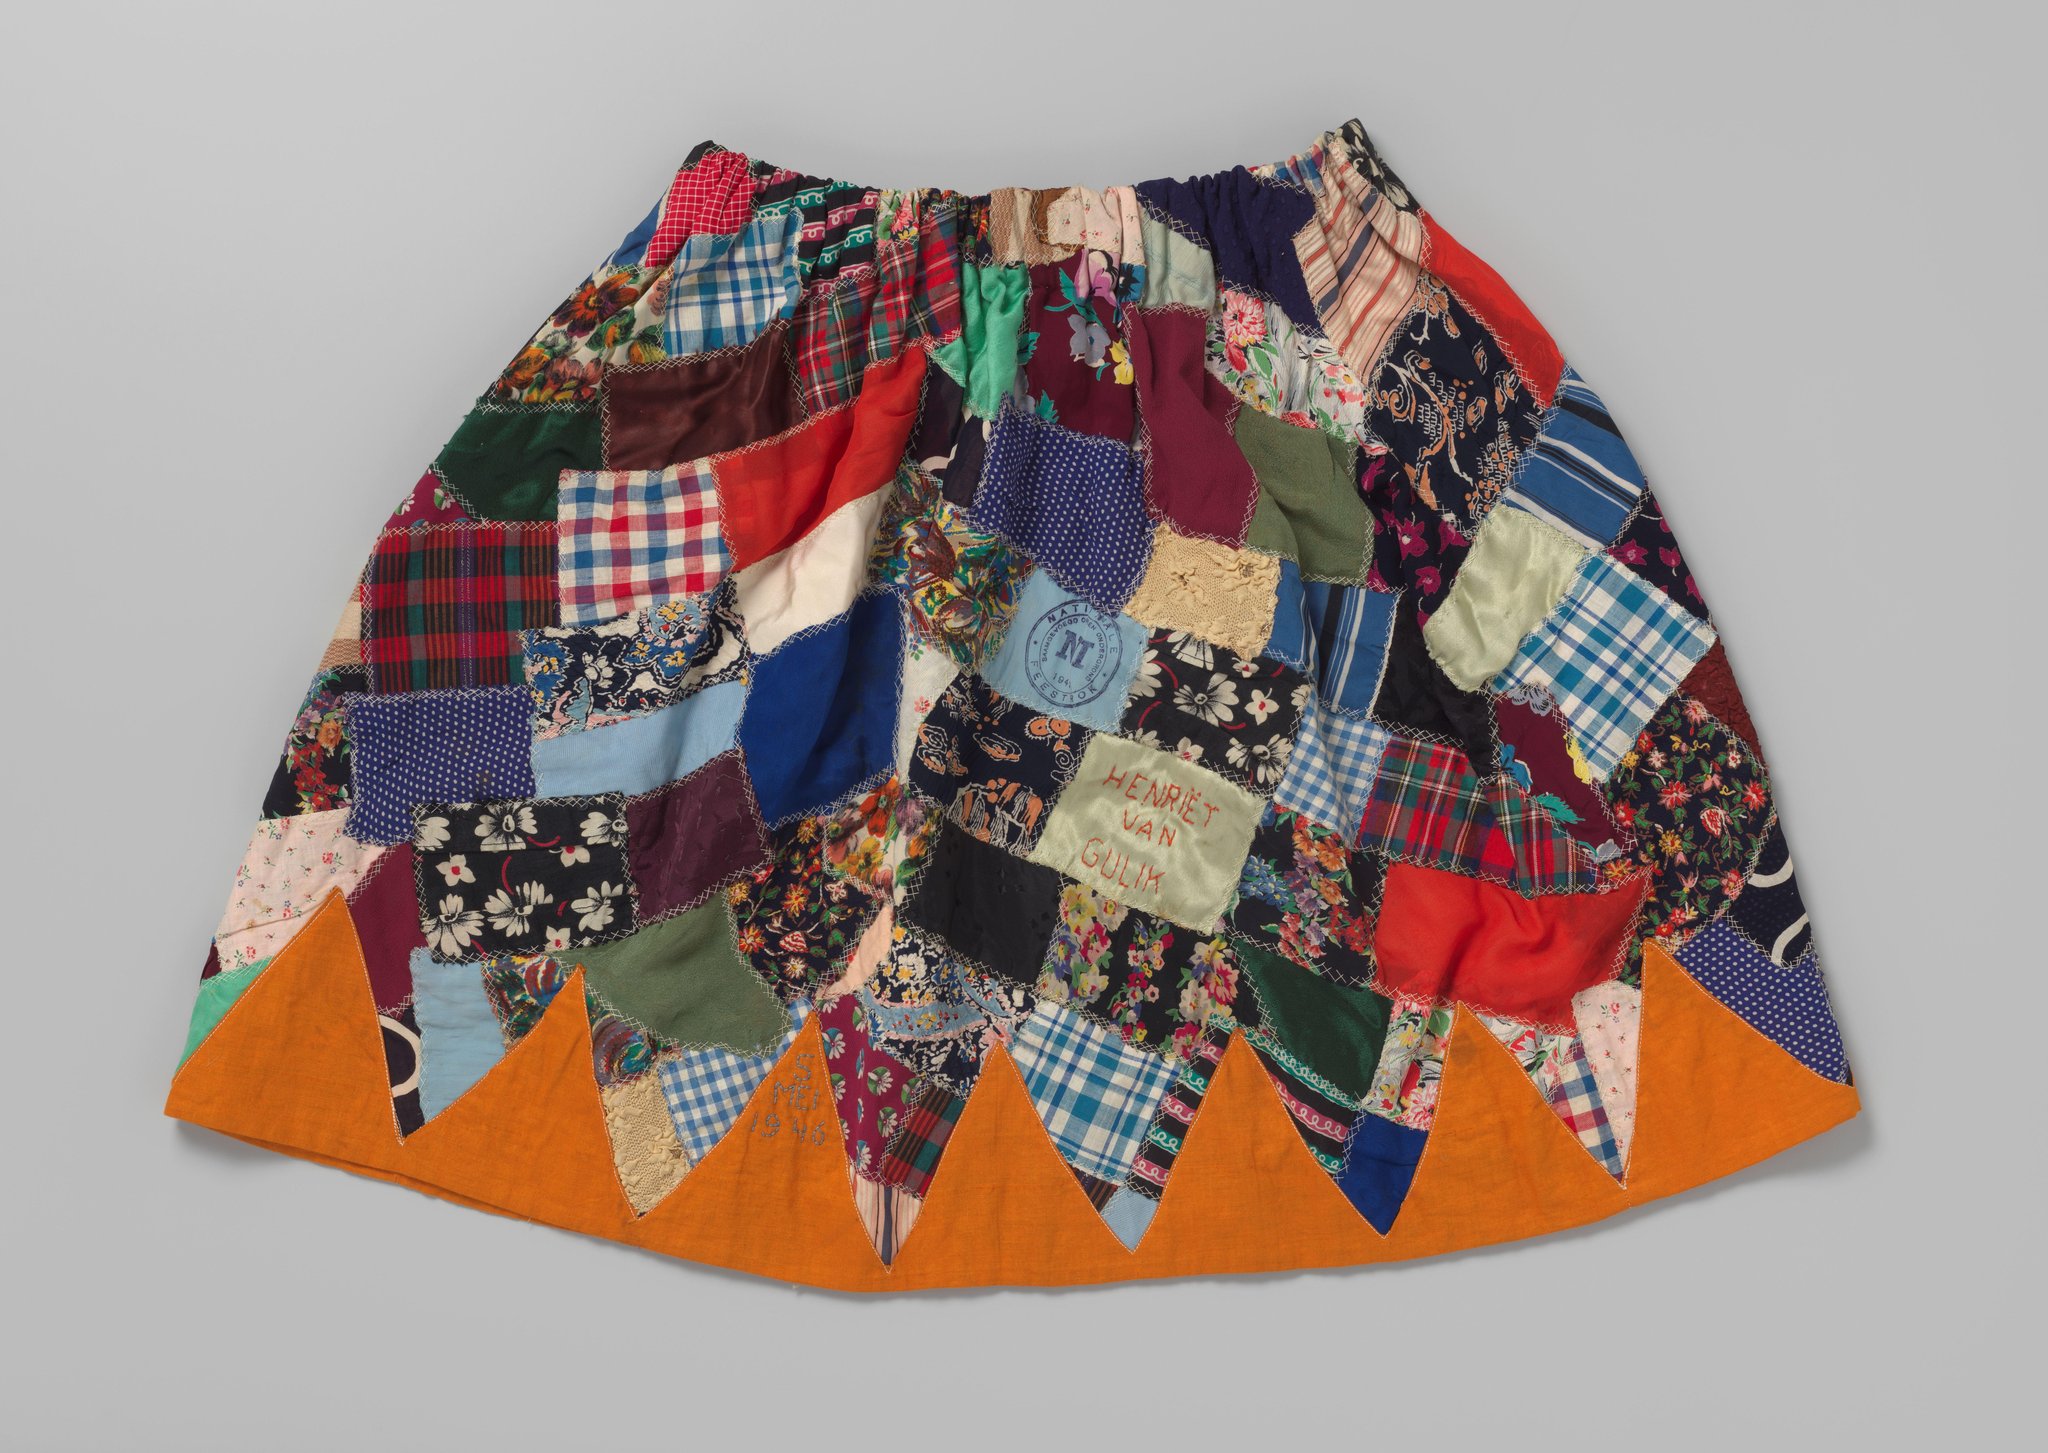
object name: skirt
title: Nationale feestrok of bevrijdingsrok samengesteld uit talloze lapjes stof, geborduurd met '19 Dec. 1935', '16 April 1945', 'Henriët van Gulik' en voorzien van de stempel 'Nationale Feestrok..., 1947'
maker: e.h. van gulik-van lennep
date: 1940-1945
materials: cotton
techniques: damask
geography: netherlands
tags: henriet van gulik, amsterdam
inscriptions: date: ‘16 April 1945’, date: ‘5 mei 1946’, name: ‘HENRIET VAN GULIK’, stamp: ‘Nationale feestrok, samengevoegd op één ondergrond, 1947’, date: ‘19 Dec. 1935’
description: Feestrok van Henriët van Gulik, 11 jaar - De data van haar geboorte, de bevrijding en de eerste keer dat zij de rok droeg zijn op de rok geborduurd. In 1947 werd de rok gestempeld in Groningen.